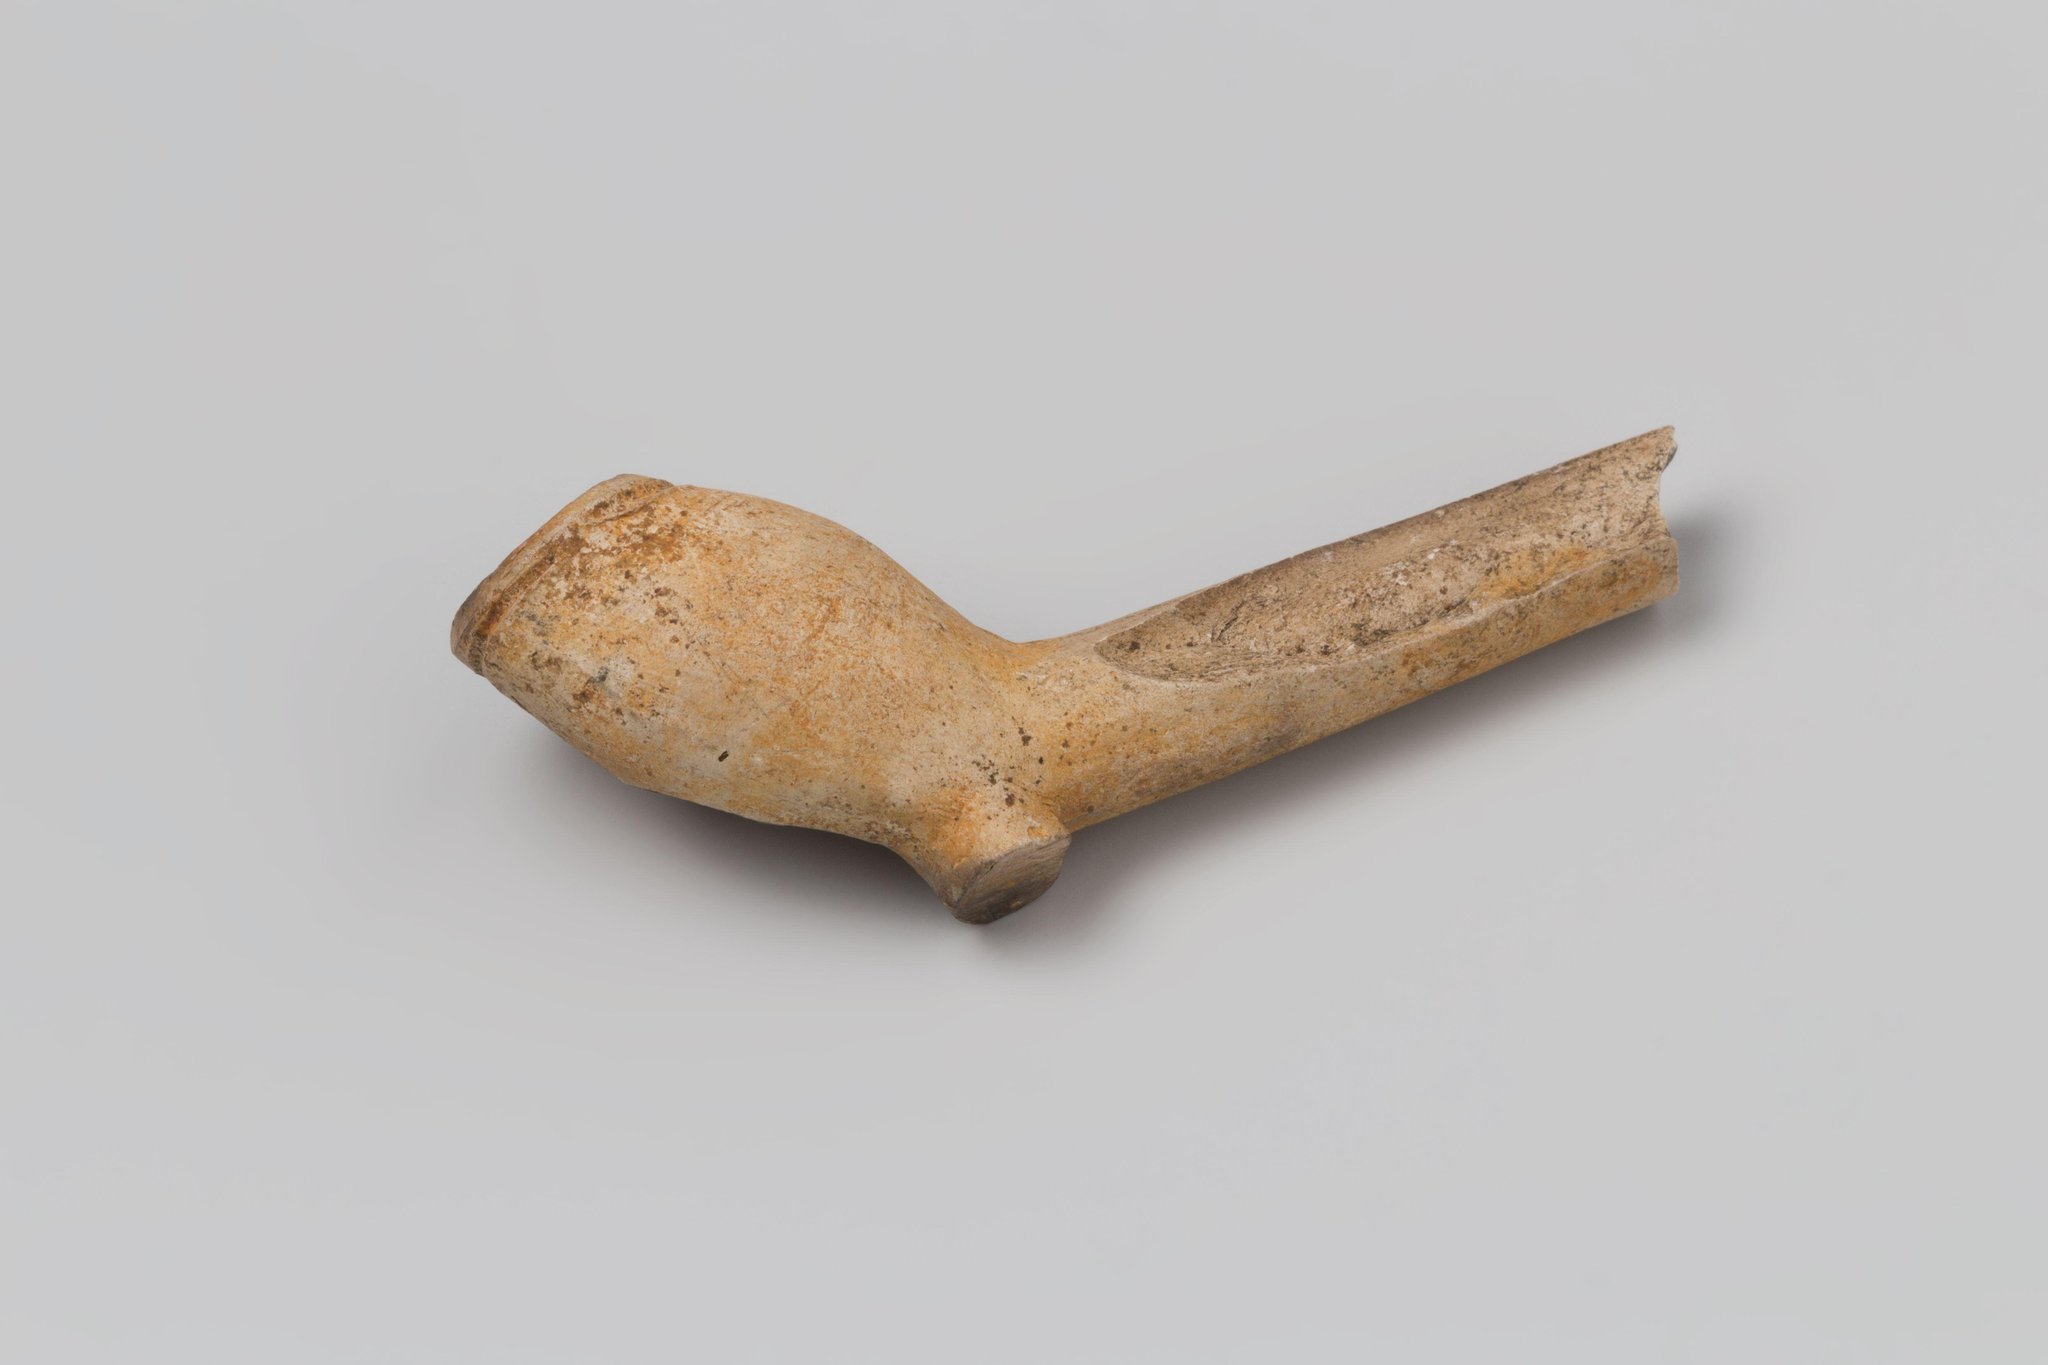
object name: pipe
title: Tabakspijp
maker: Anonymous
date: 1400-1950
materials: clay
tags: zeeuwsche uytkyck